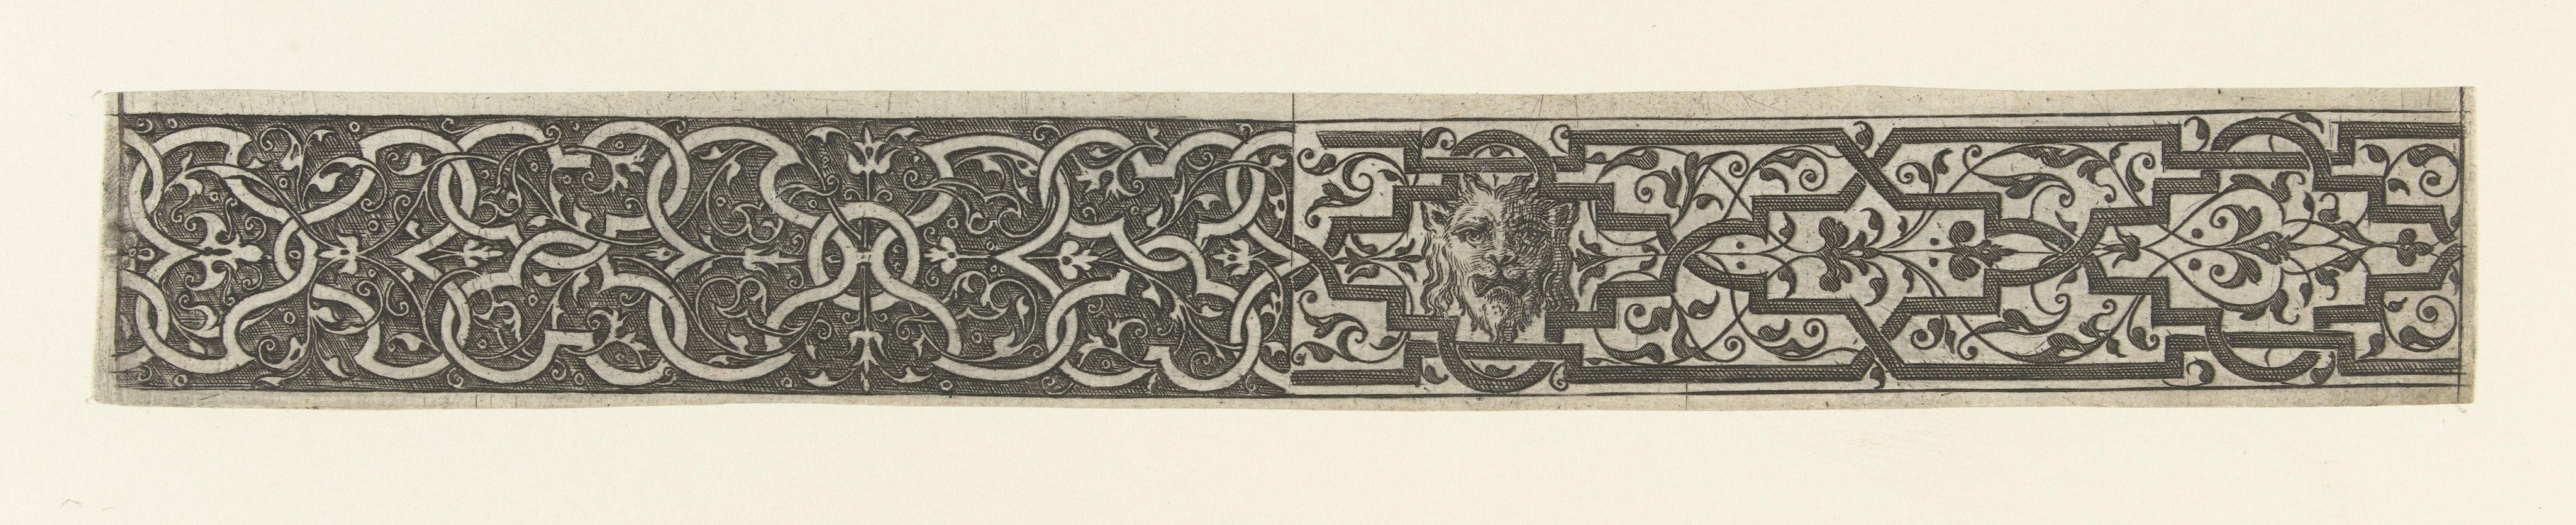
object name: ornament print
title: Variarum protractionum quas vulgo maurusias vocant (...)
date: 1550-1580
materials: paper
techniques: engraving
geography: netherlands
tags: mask, mascaron ~ ornament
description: Onderste van drie friezen, waarvan de linker helft bestaat uit witte moresken op een zwart fond en de rechter helft uit zwarte moresken op een witte ondergrond. Rechts van het midden bevindt zich een mascaron. Een van 15 bladen afkomstig uit een serie van 23 friezen met titelblad.